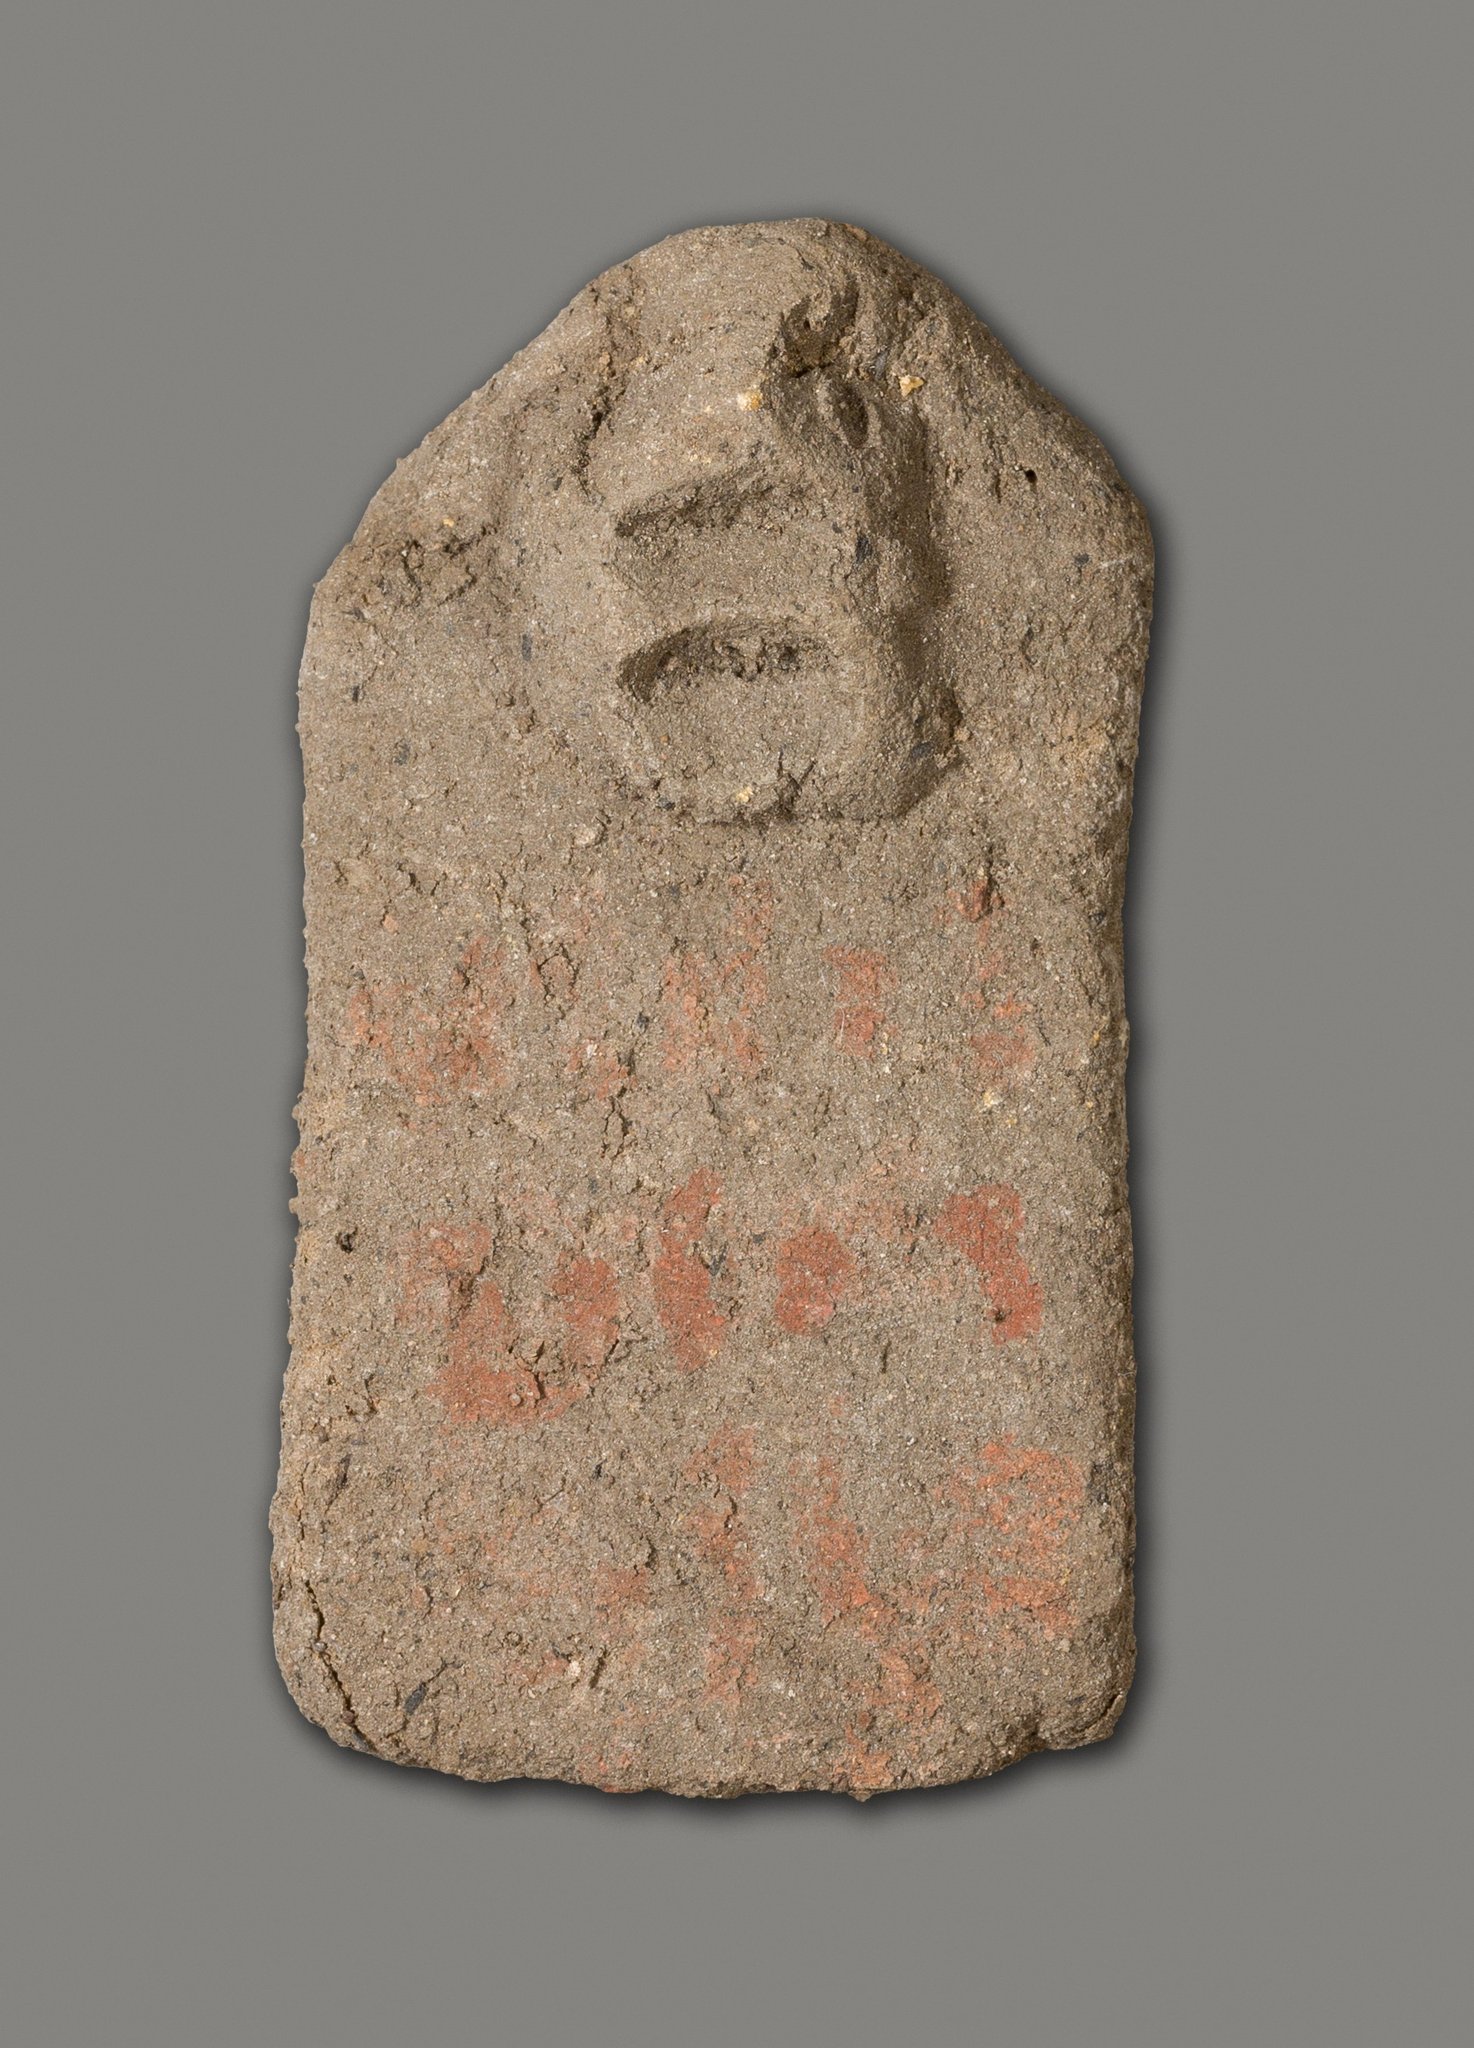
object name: figure, magical, execration, tablet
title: Magical Figure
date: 1802-1550 BCE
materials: clay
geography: egypt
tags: faces